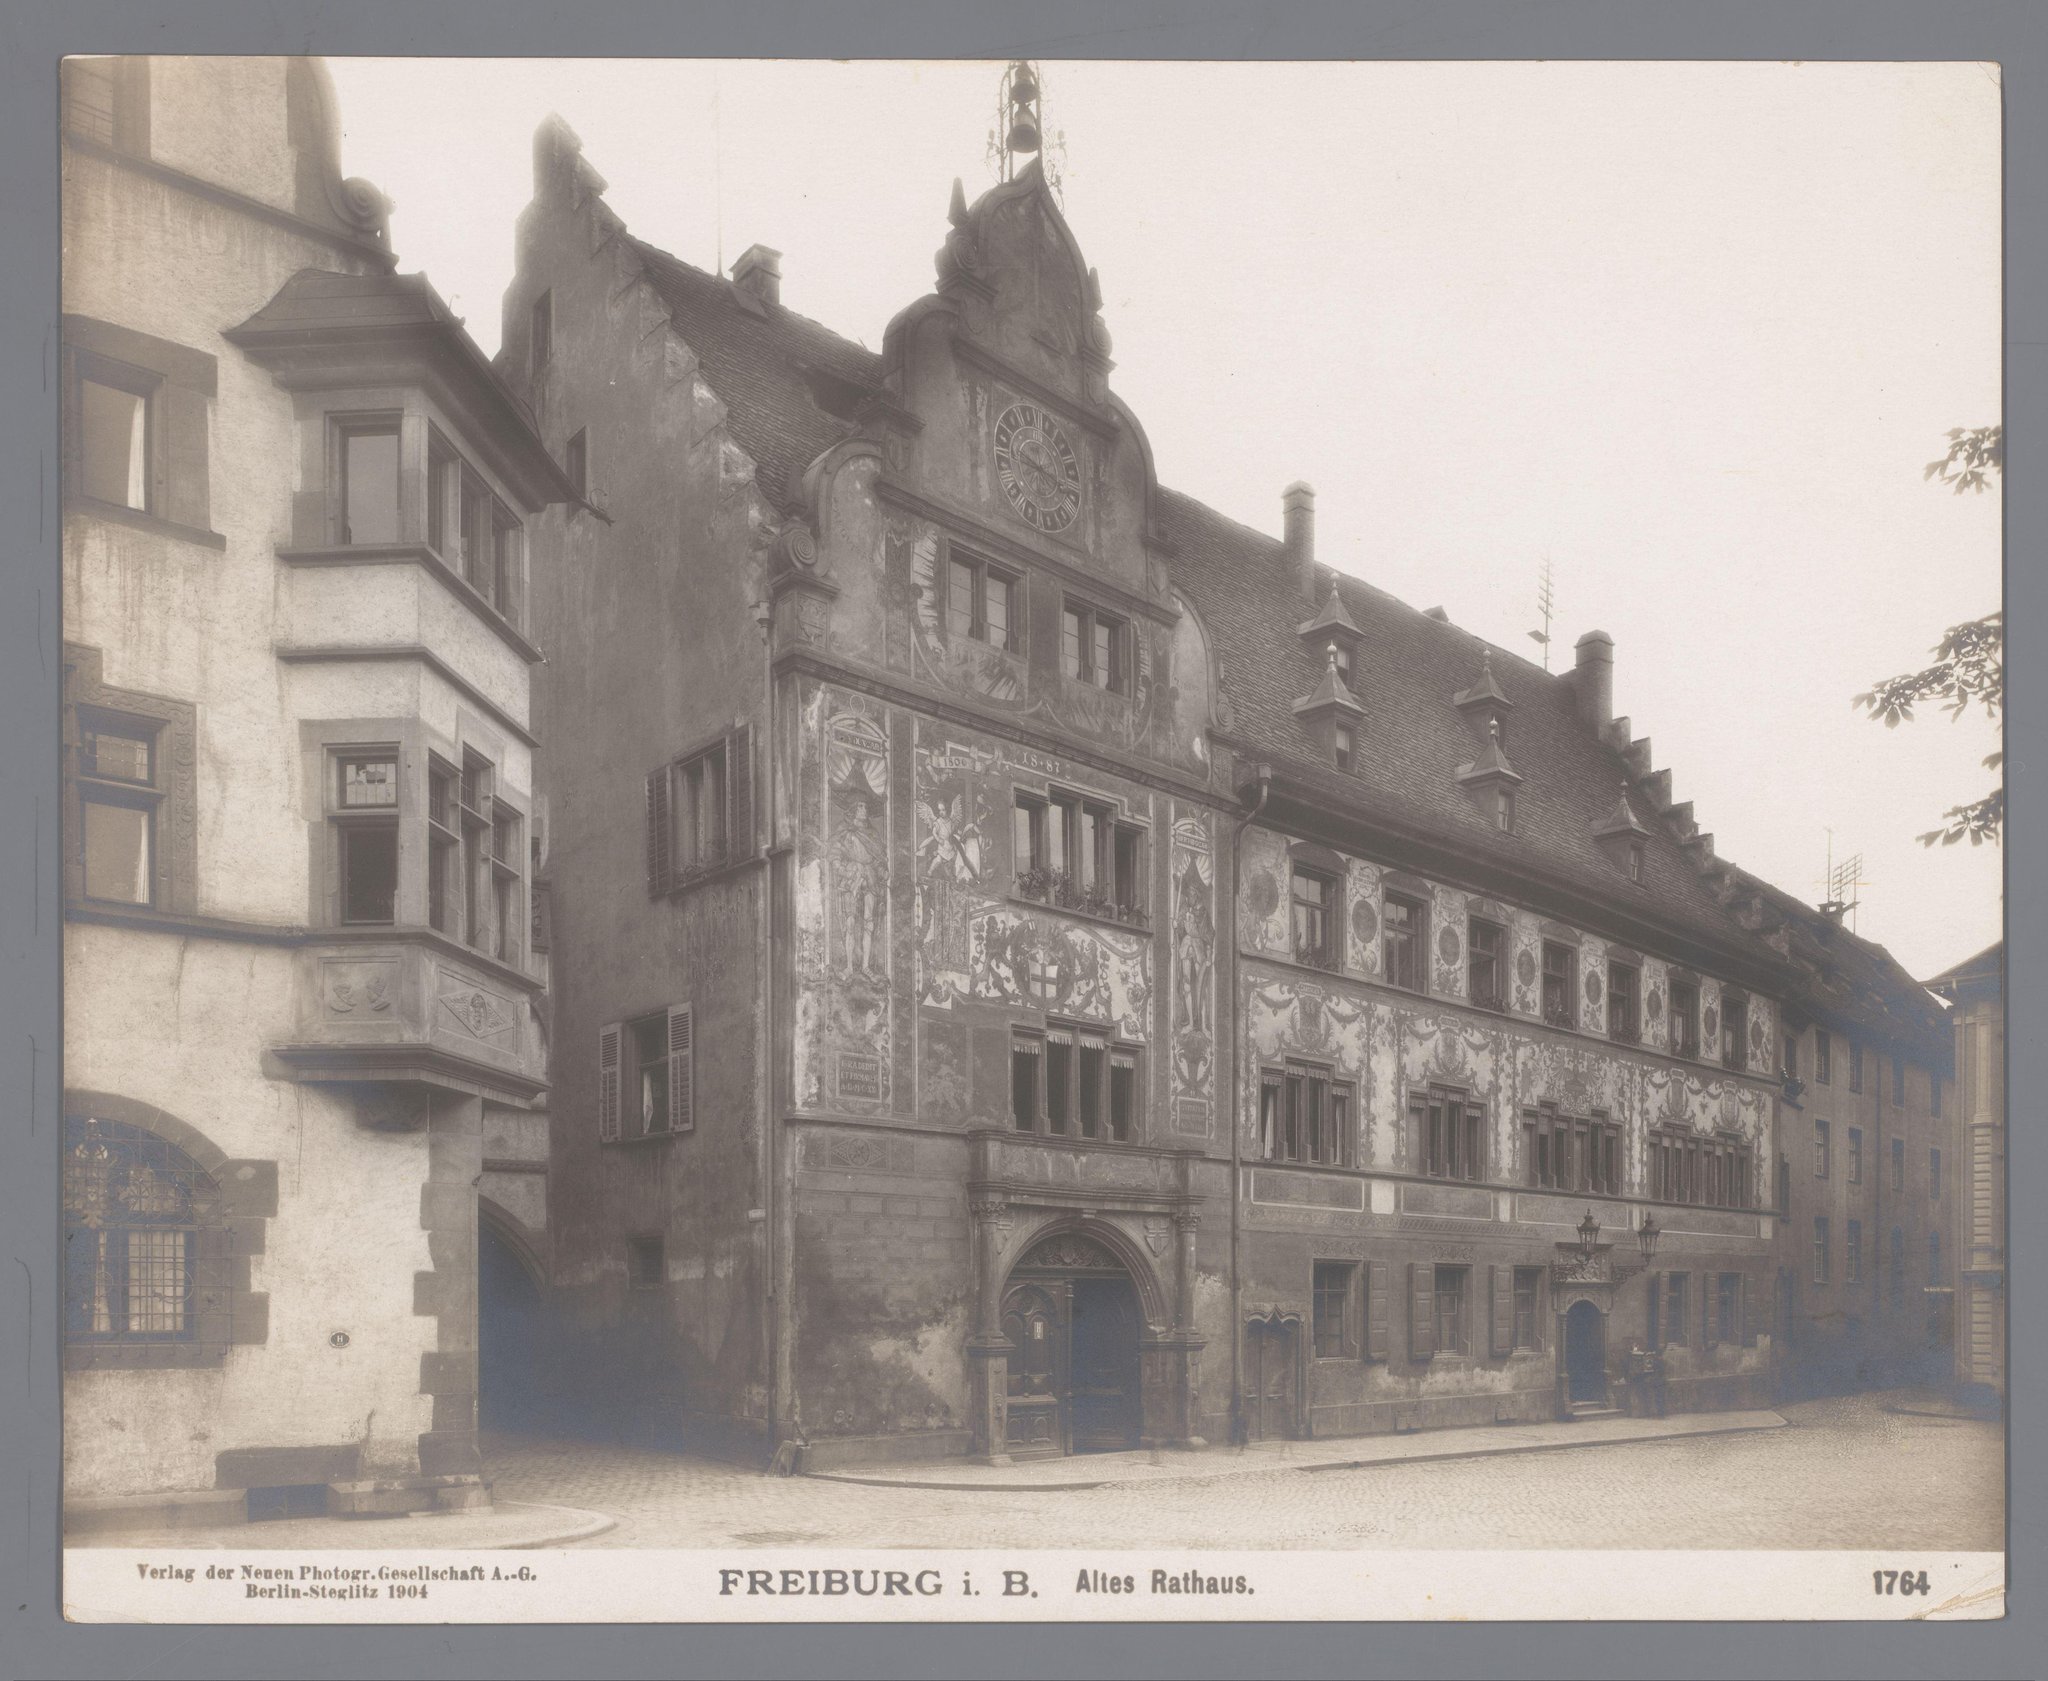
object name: photograph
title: Het oude raadhuis, Freiburg im Breisgau, Baden-Württemberg, Duitsland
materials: paper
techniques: gelatin silver print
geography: germany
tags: freiburg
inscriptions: inscription: ‘Verlag der Neuen Photogr.Gesellschaft A.-G.//Berlin-Stieglitz 1904’, number: ‘1764’, inscription: ‘FREIBURG i. B. Altes Rathaus.’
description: Gezicht op het rijk beschilderde oude raadhuis van Freiburg im Breisgau, Duitsland.